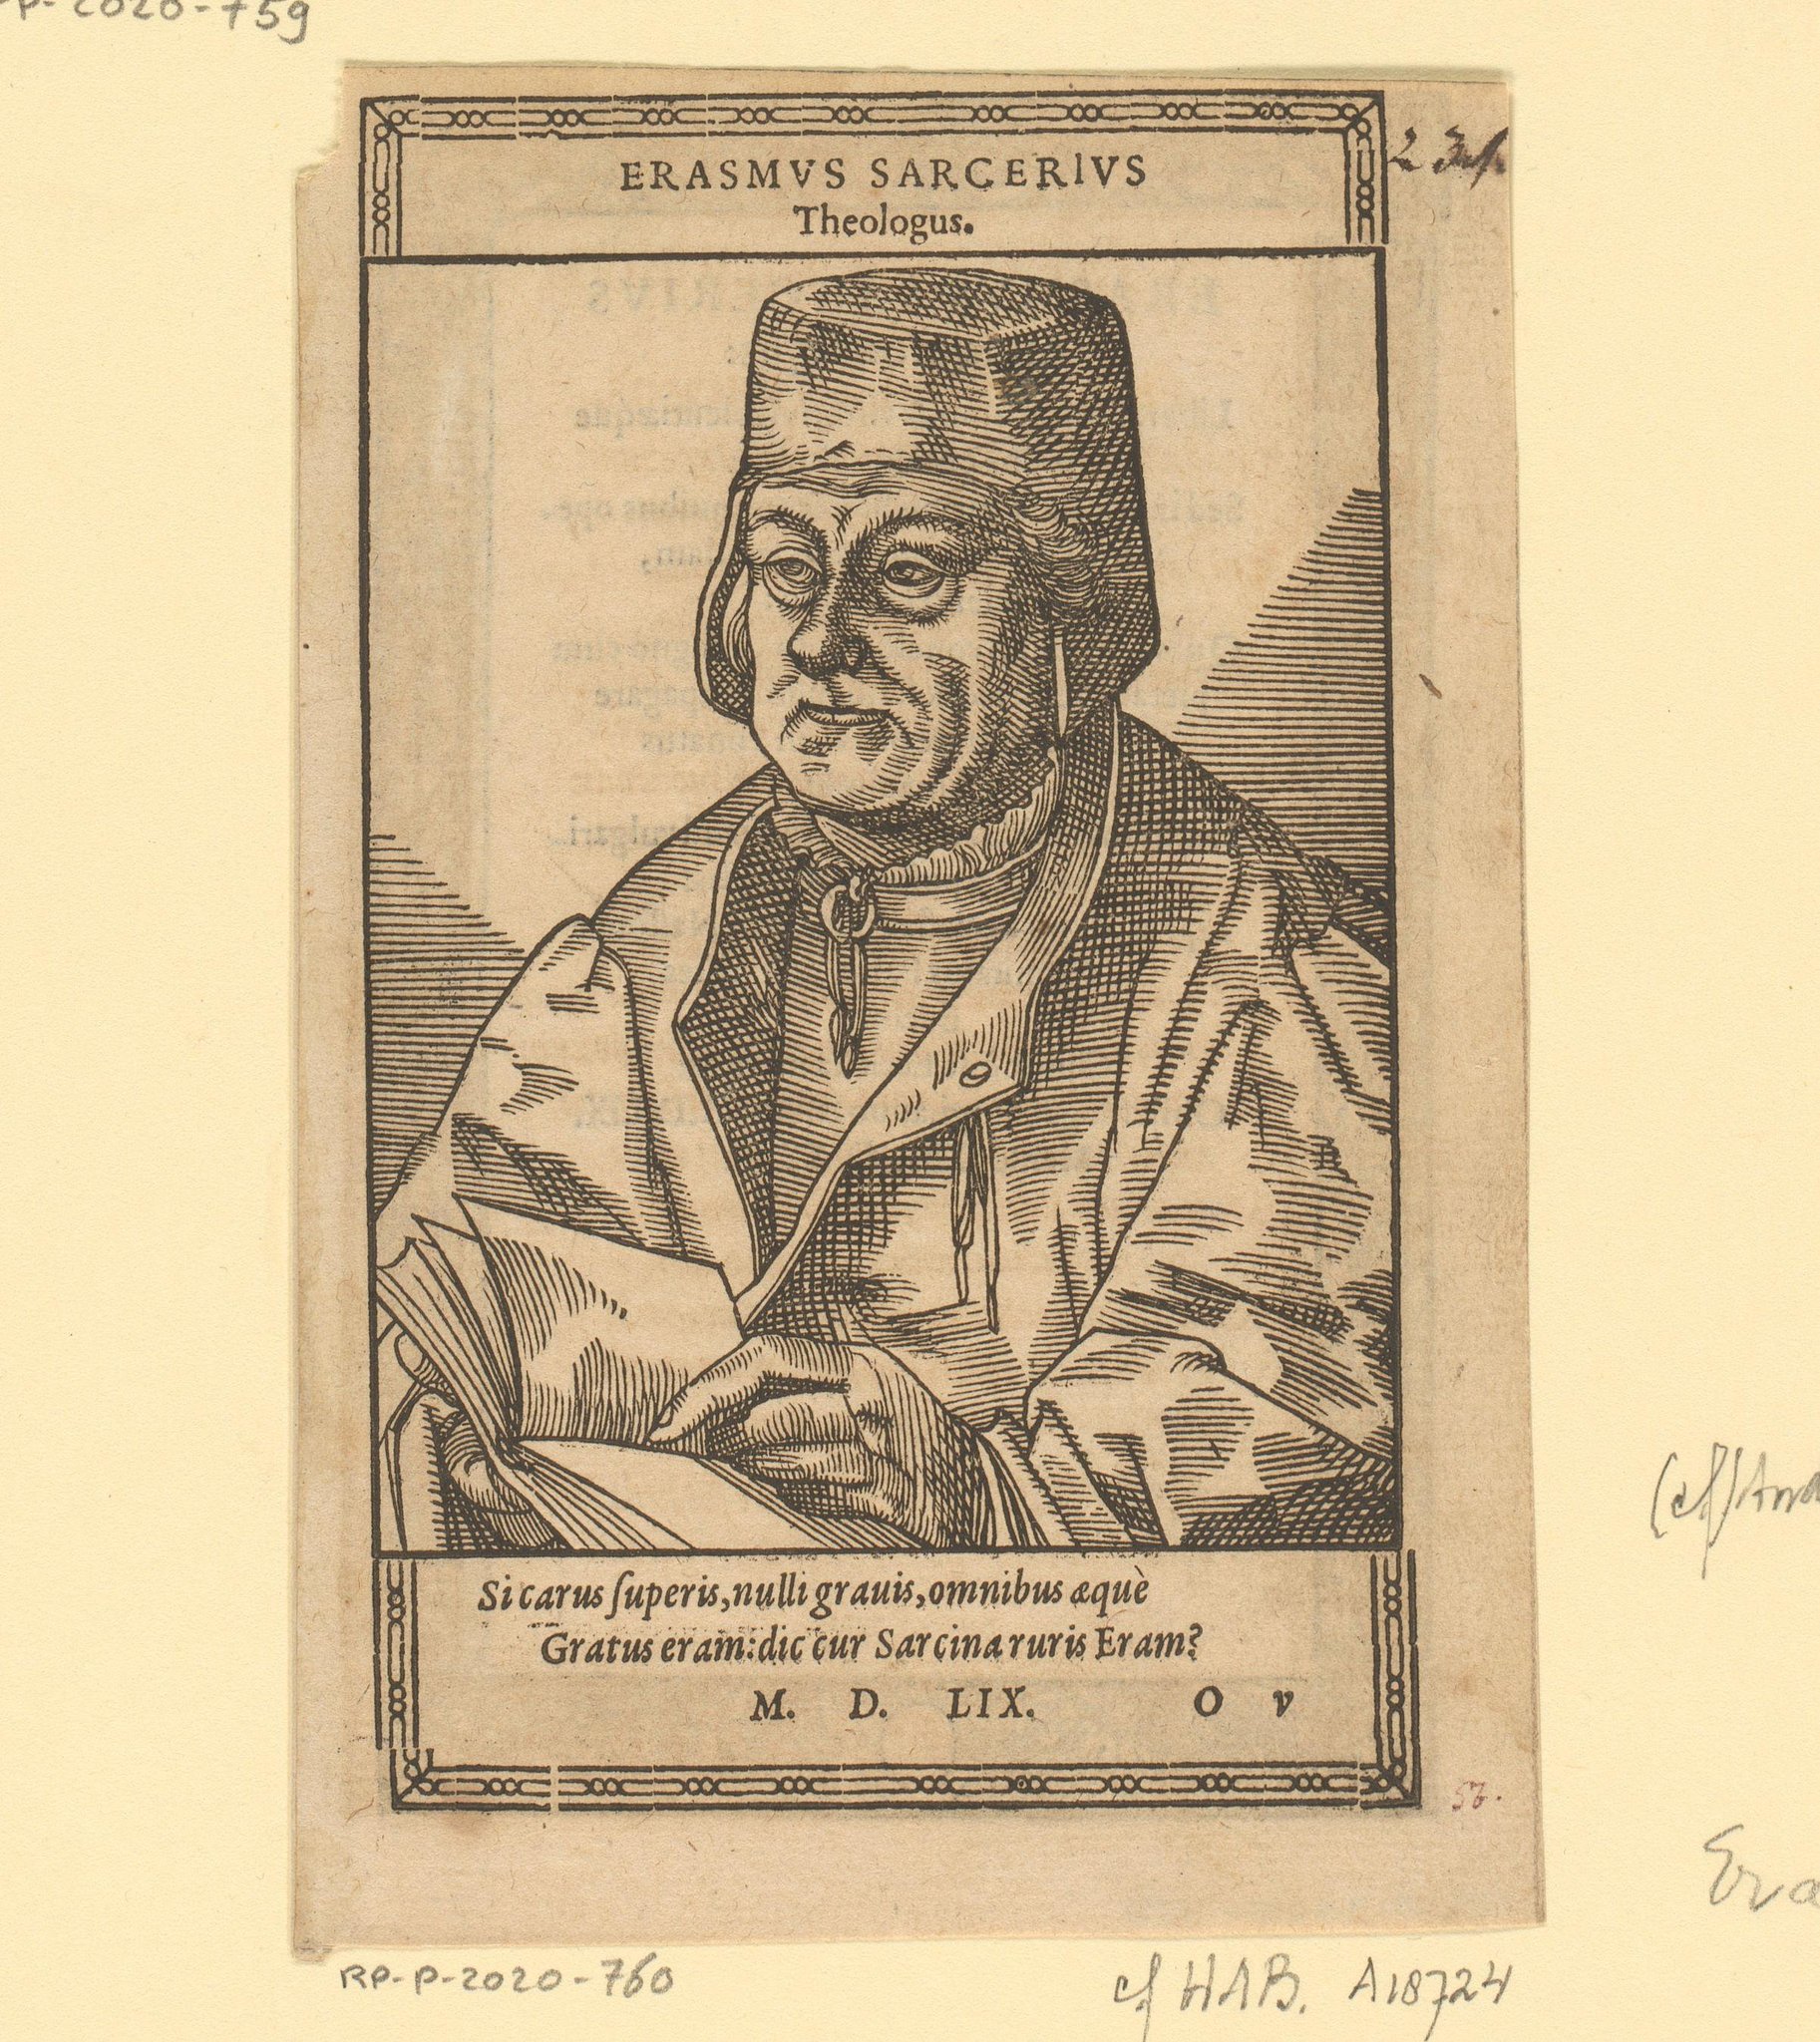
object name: print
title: Portret van Erasmus Sarcerius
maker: bernhard jobin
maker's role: printer, publisher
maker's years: 1545-1593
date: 1587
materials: paper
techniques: letterpress printing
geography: straatsburg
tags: theologian, historical persons, book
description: Prent uit: Reusner, Nikolaus. Icones sive imagines virorum literis illustrium (...). Straatsburg: Bernhard Jobin, 1587. Prent ook gebruikt in de Duitse editie, uitgegeven in hetzelfde jaar, en de 1590-editie. Prent ook gebruikt in latere publicaties.